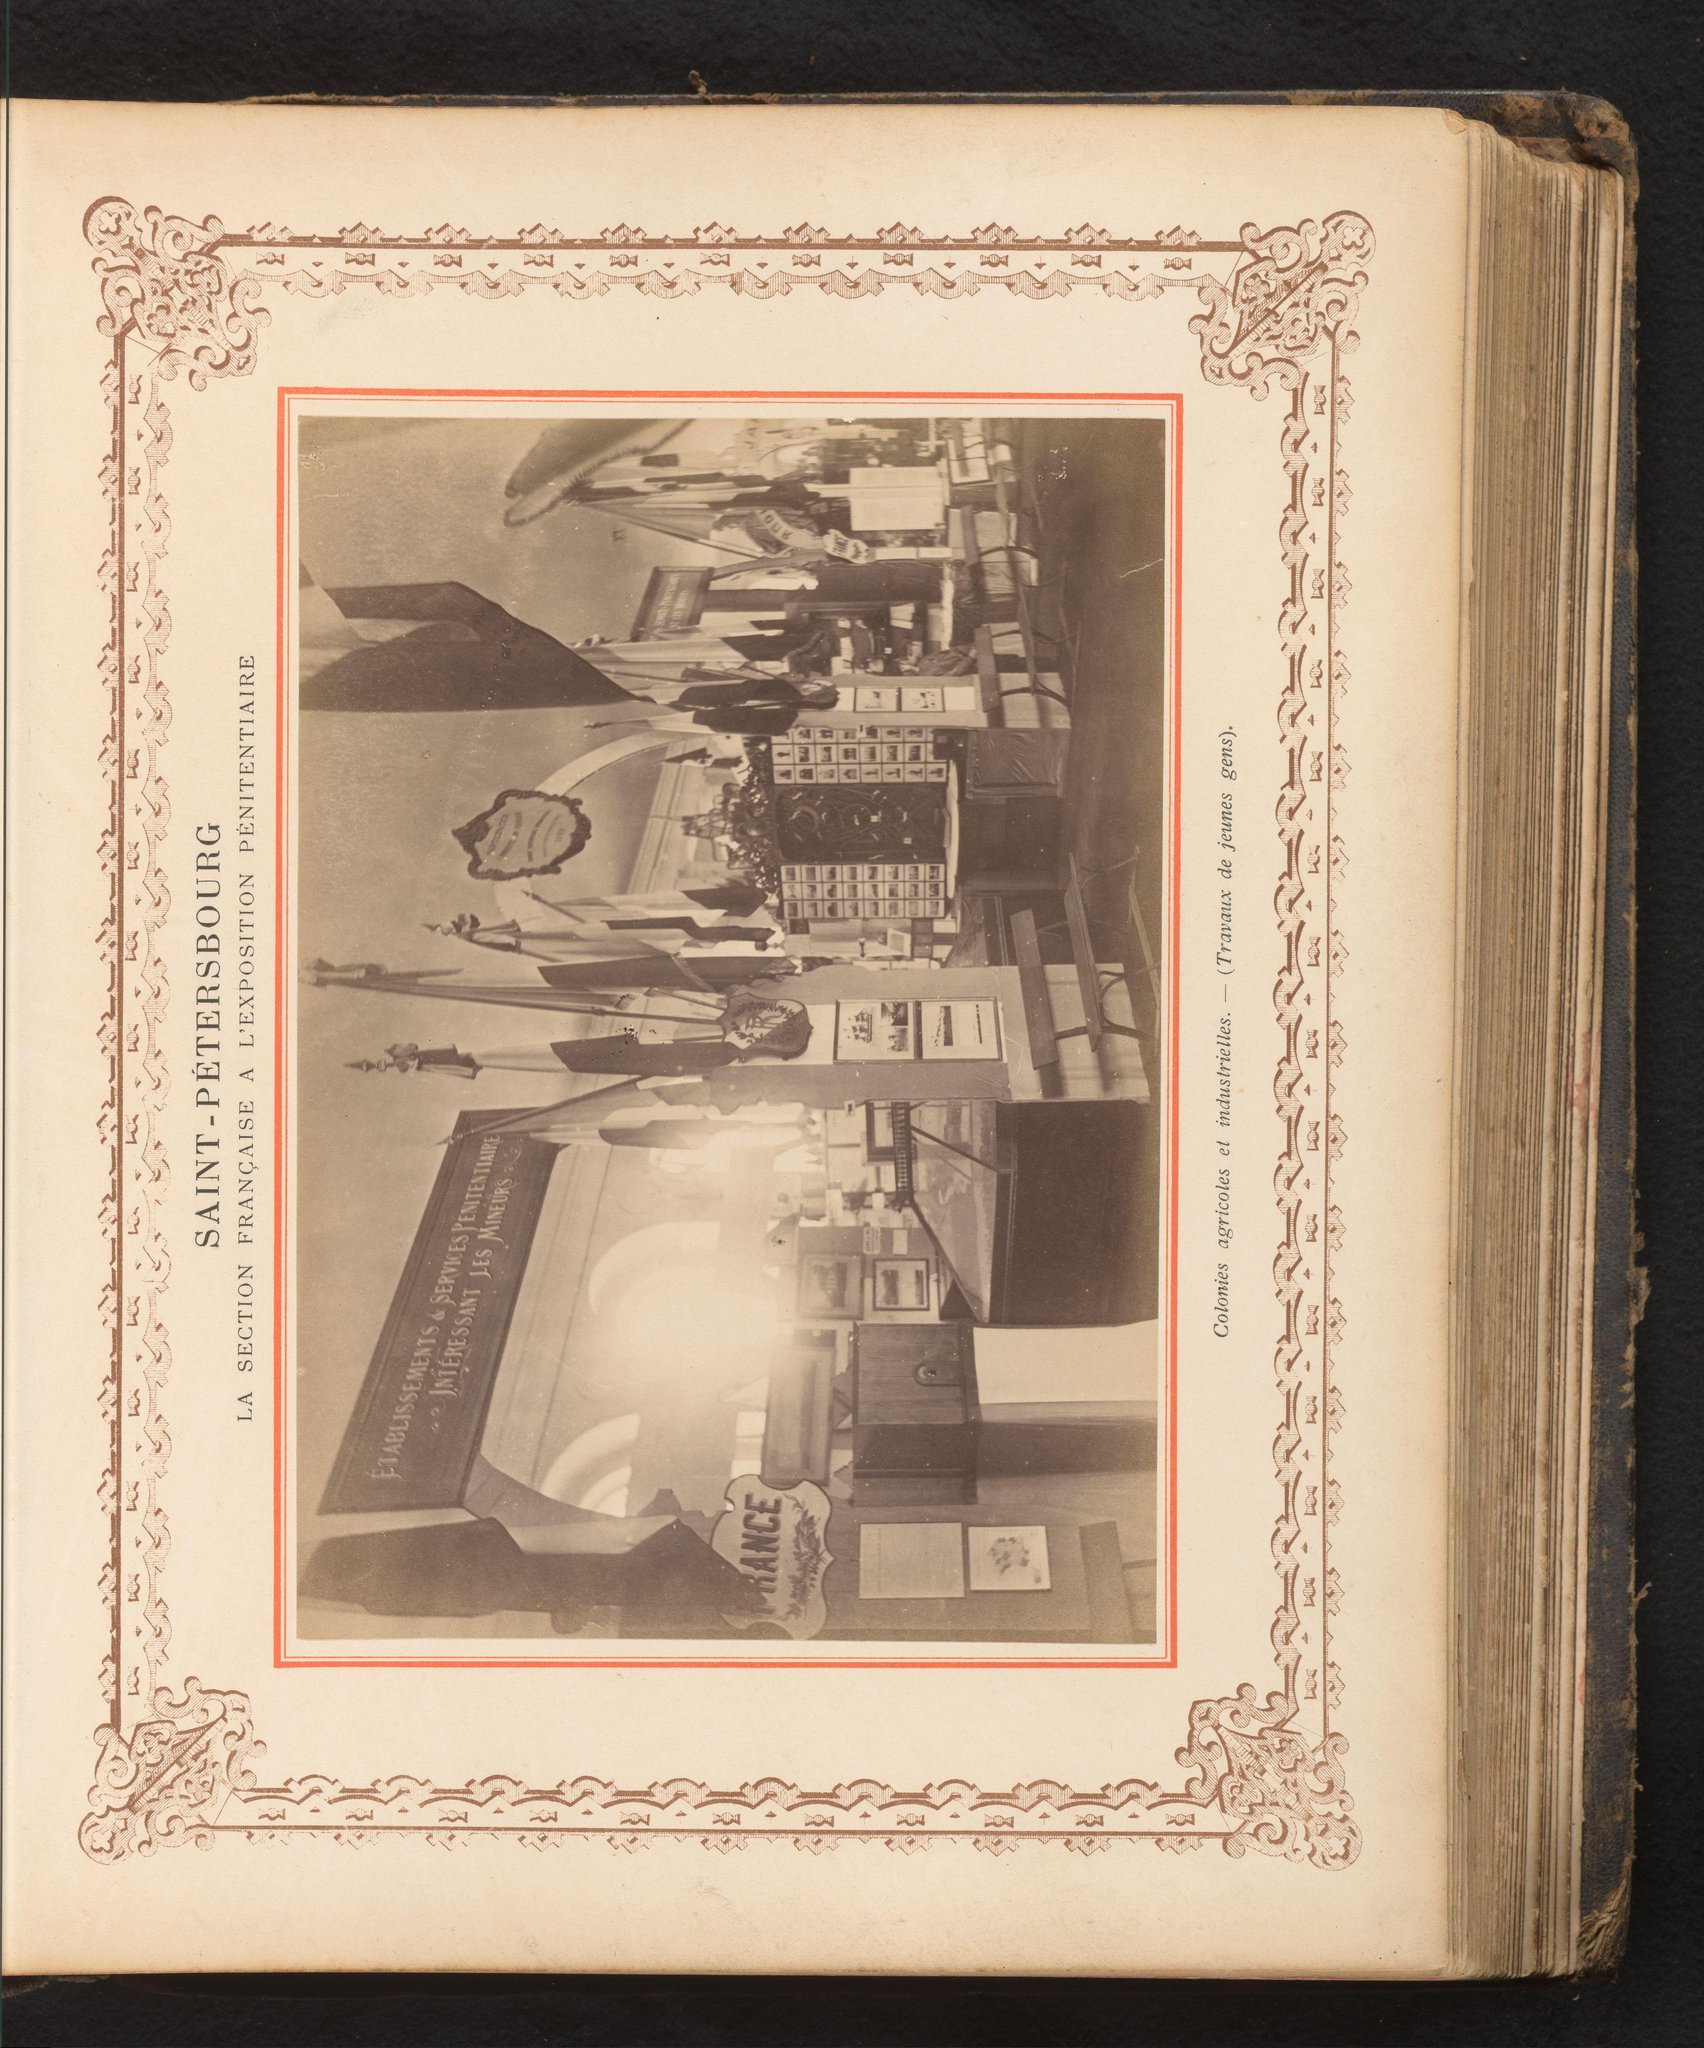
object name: page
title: Saint-Pétersbourg - La Section Française à l'Exposition Pénitentiaire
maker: Anonymous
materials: photographic support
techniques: albumen print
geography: sint-petersburg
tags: trade exhibition, industries fair, criminal law; punishment